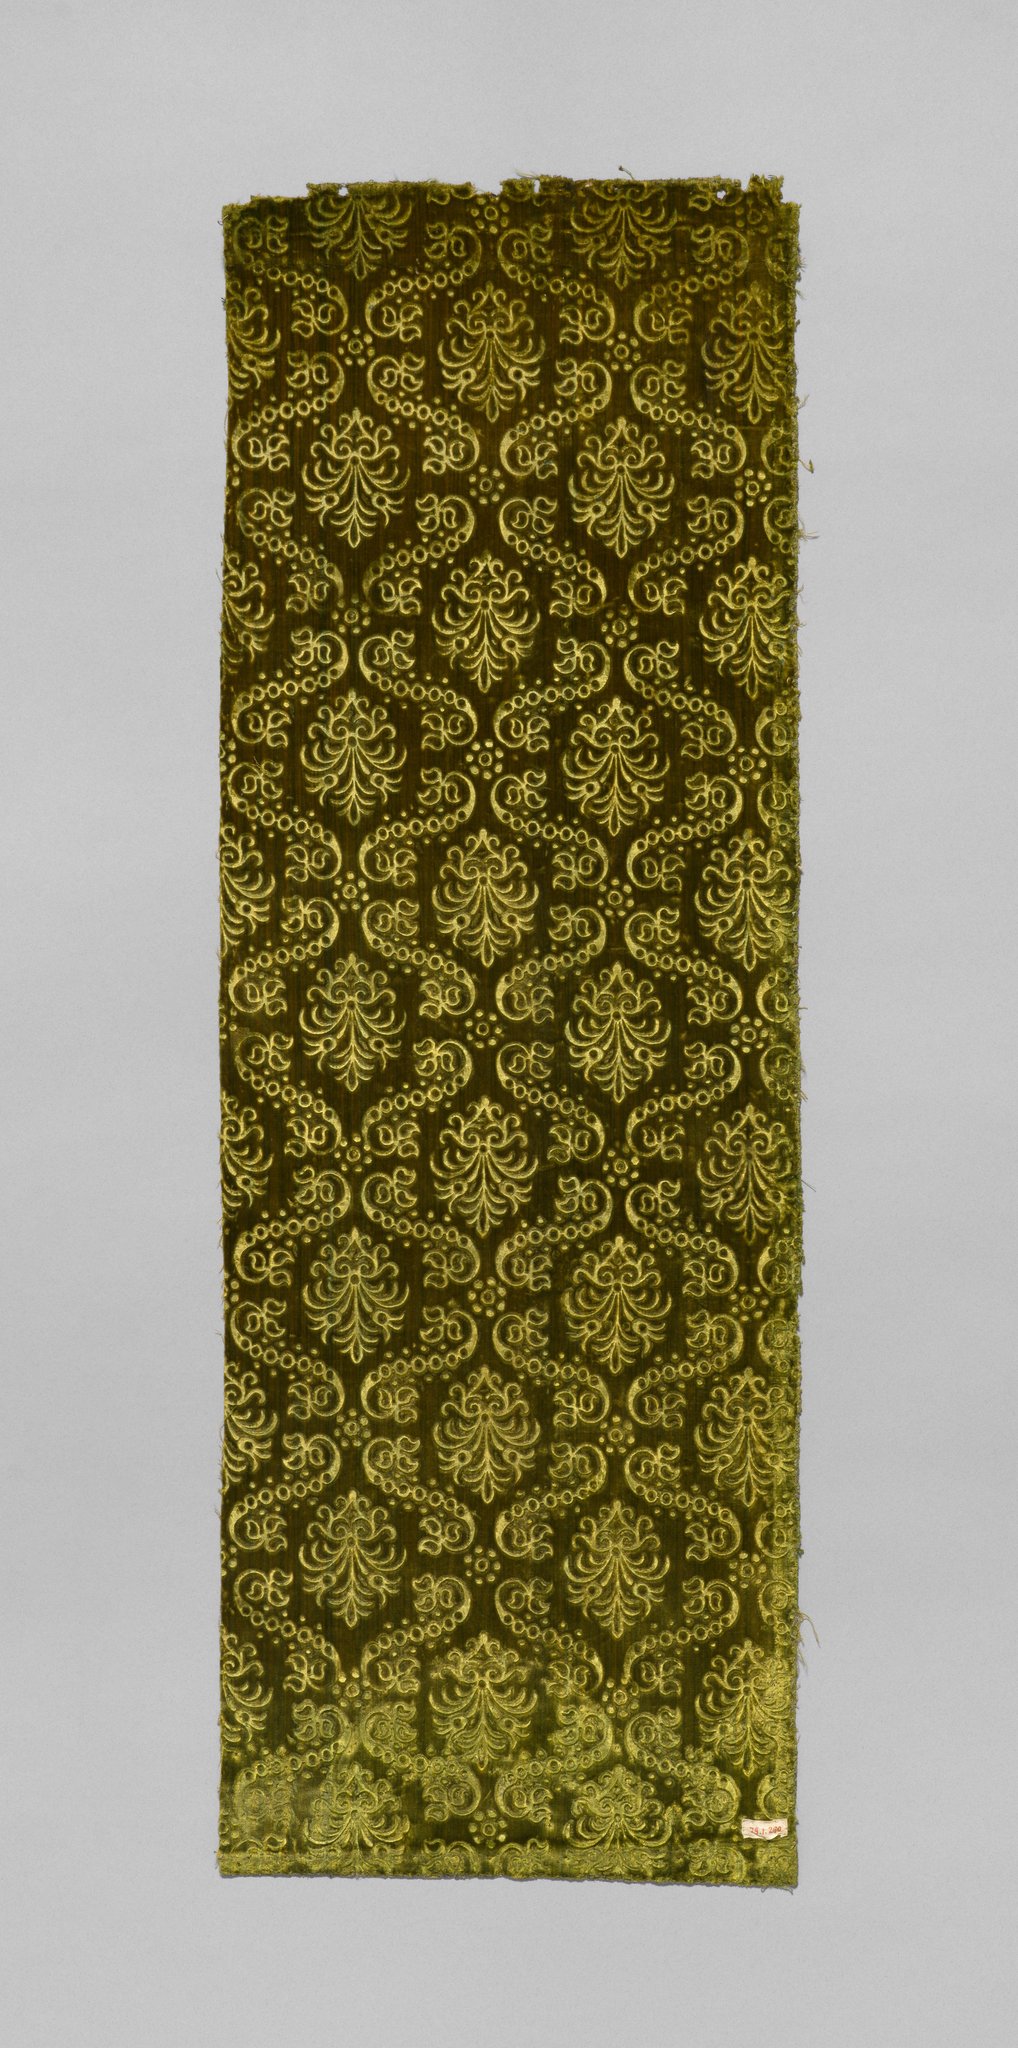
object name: piece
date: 1501-1600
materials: silk